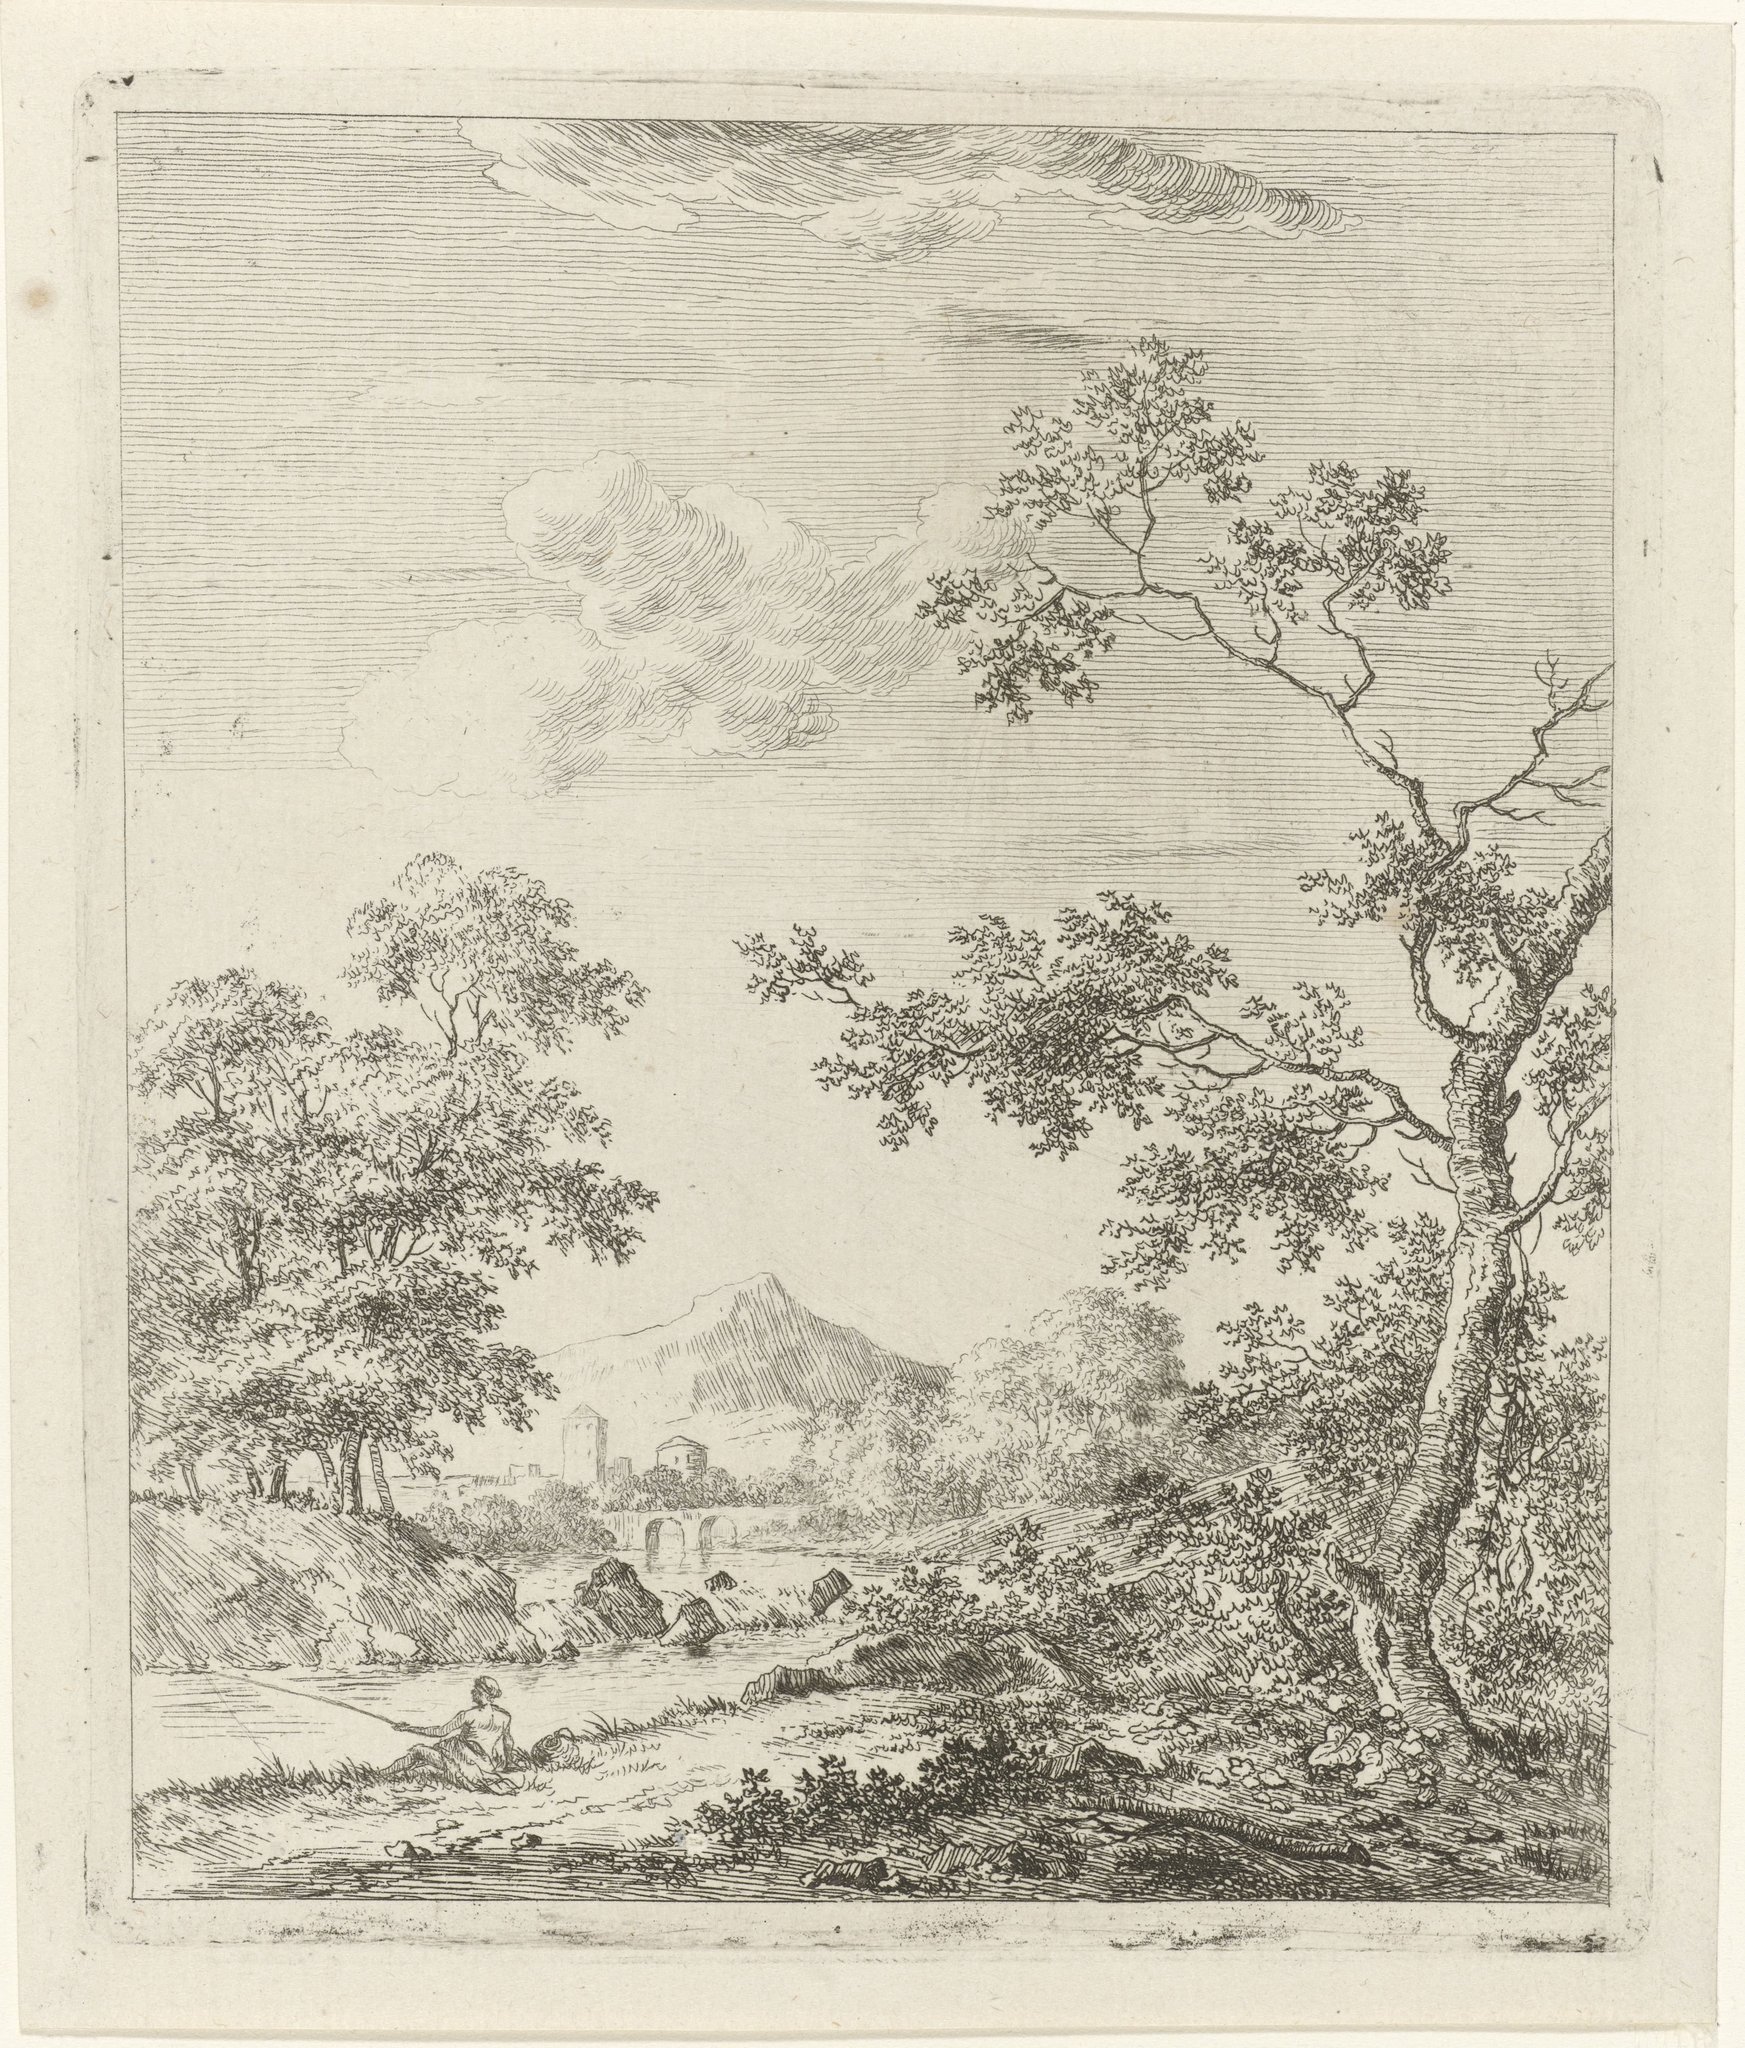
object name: print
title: Landschap met visser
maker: johannes janson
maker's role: draughtsman, painter, print maker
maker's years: 1729-1784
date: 1761-1784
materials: paper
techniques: etching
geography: leiden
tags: herding, herdsman, herdswoman, shepherd, shepherdess, cowherd, etc., landscapes (+ landscape with figures, staffage)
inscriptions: collector's mark: Lugt 2228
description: Heuvelachtig landschap met visser zittend bij een rivier. Prent uit een serie met landschappen.